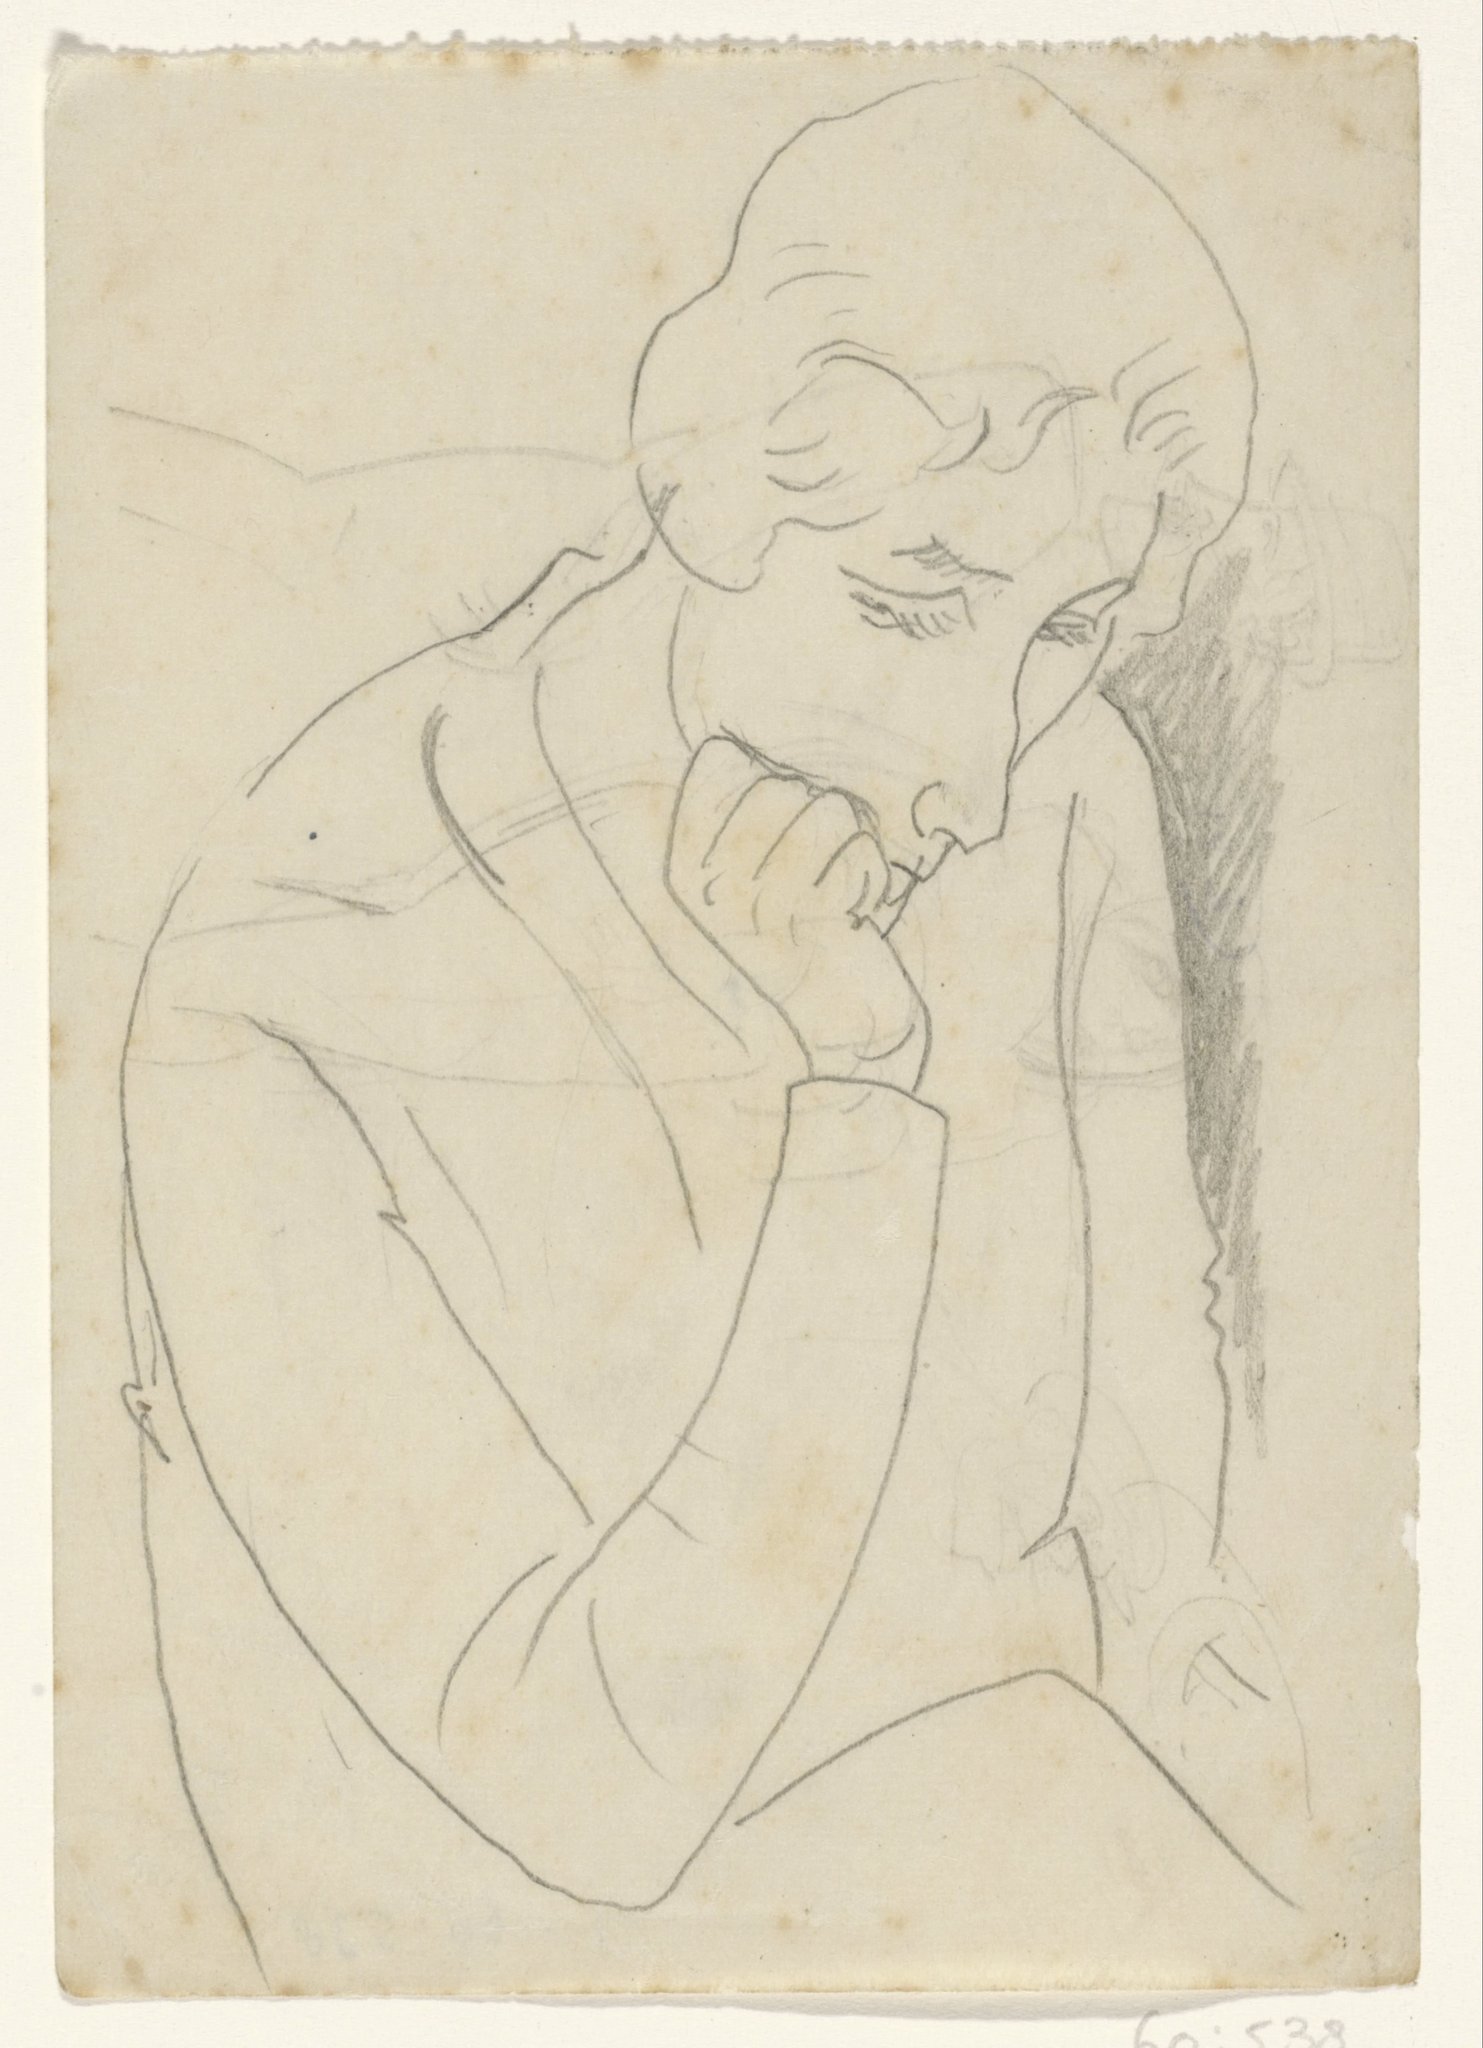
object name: drawing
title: Denkende vrouw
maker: leo gestel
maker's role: draughtsman, print maker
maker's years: 1881-1941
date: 1891-1941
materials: paper, pencil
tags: female sex; woman